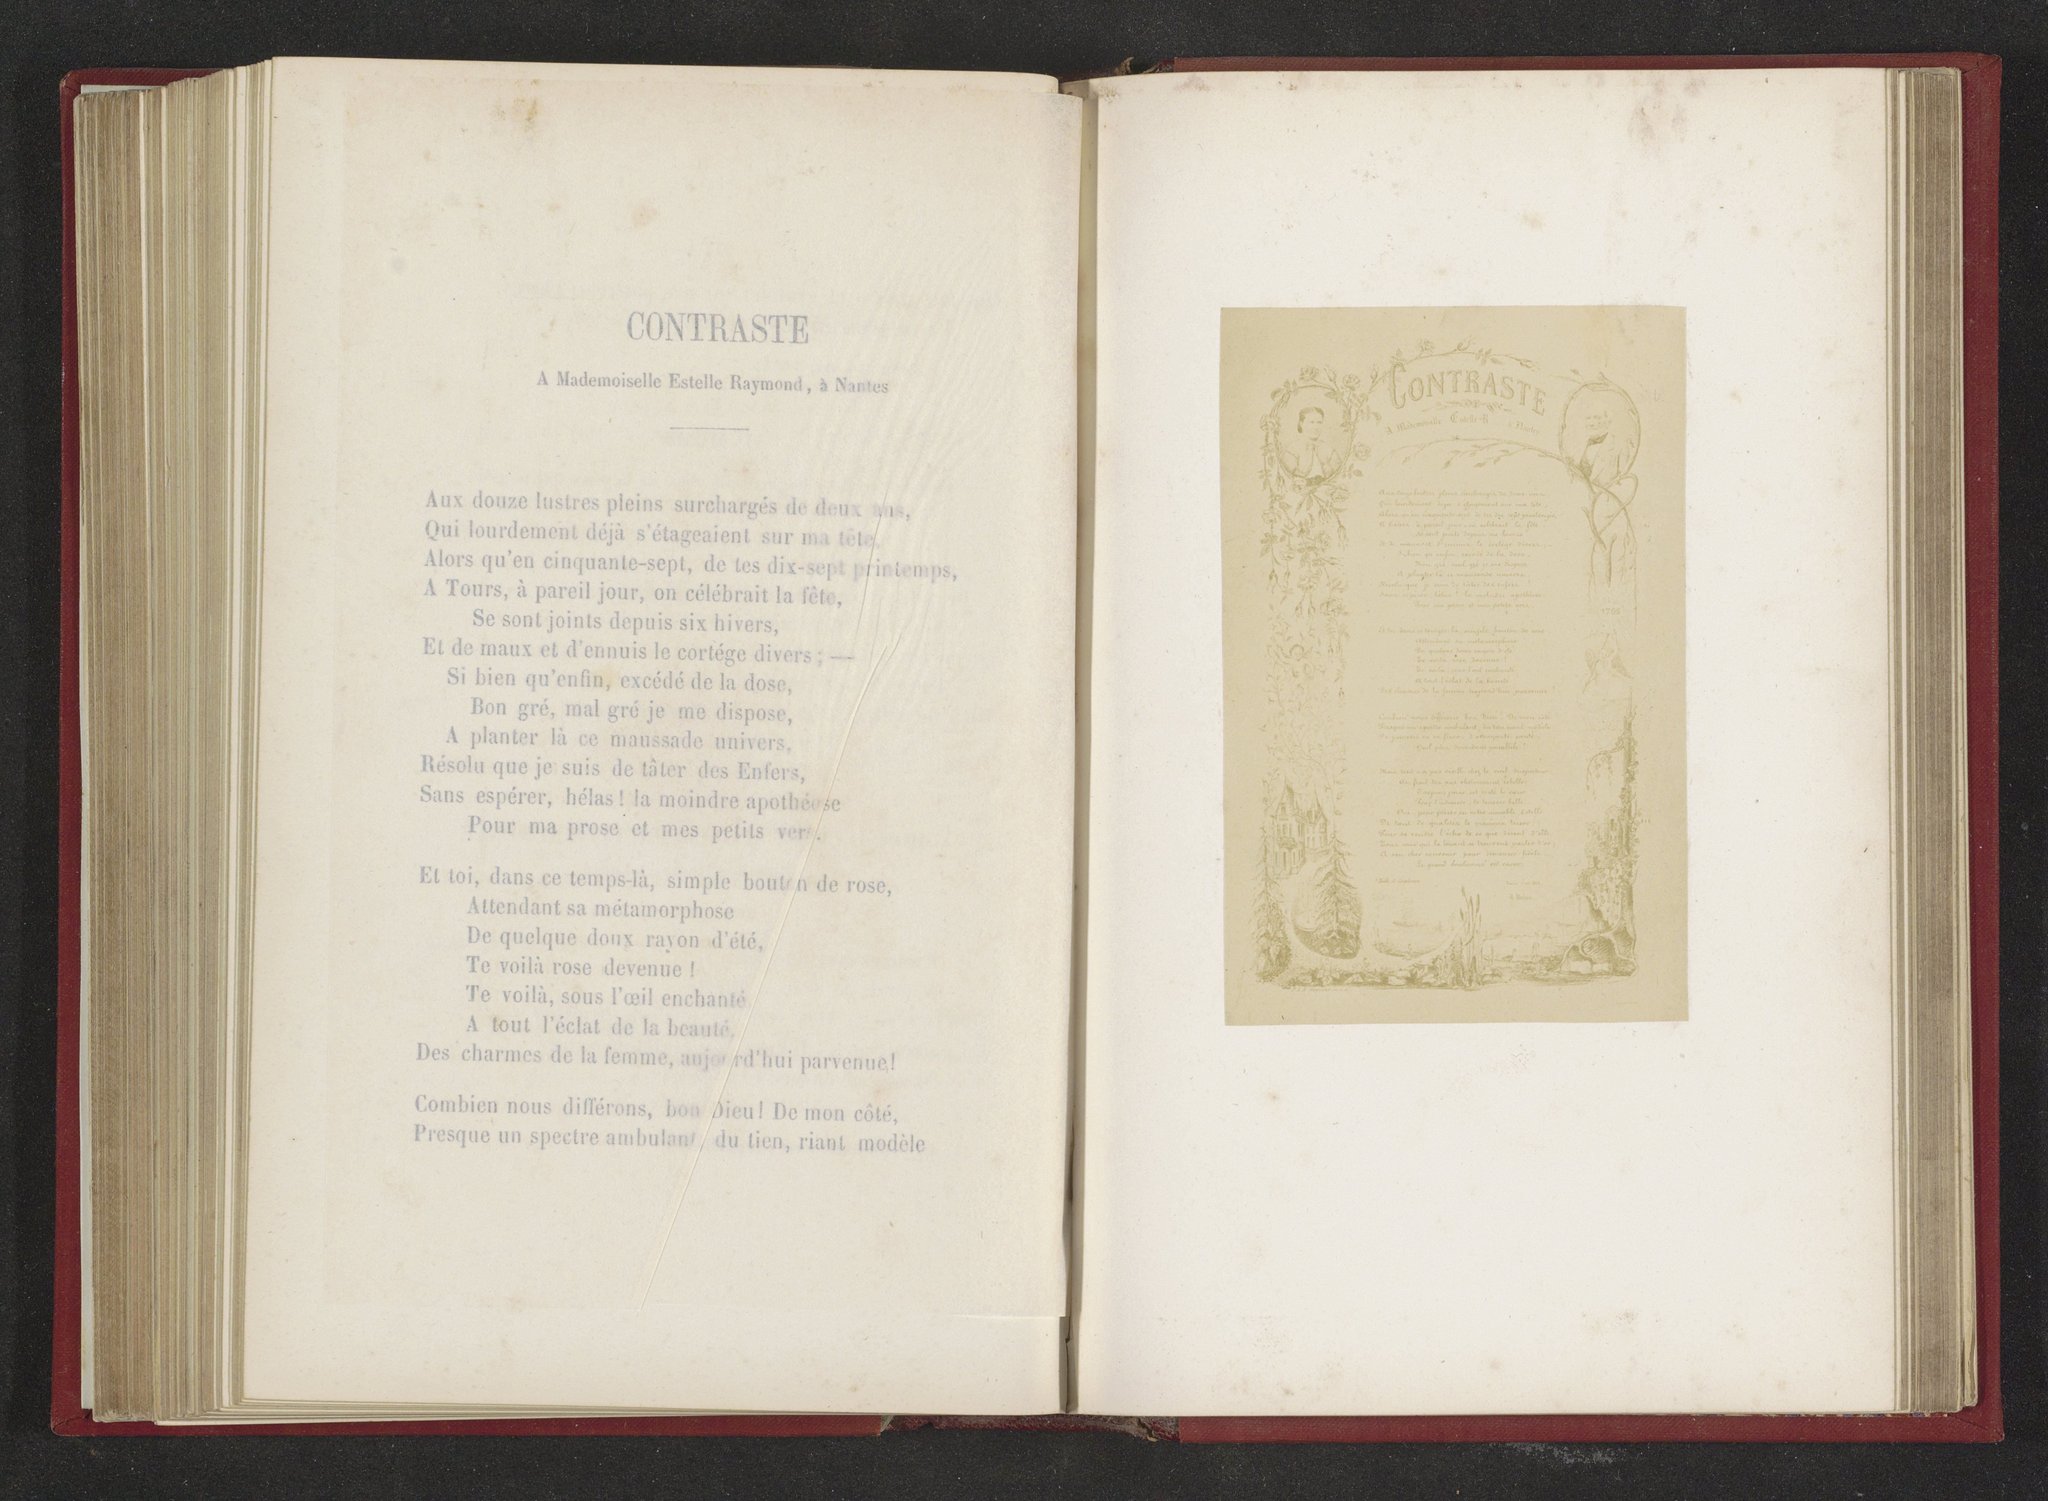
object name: page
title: Vers gedecoreerd met twee portretten en een huis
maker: collin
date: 1858-1868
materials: photographic support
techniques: albumen print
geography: paris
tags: historical persons, housing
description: Betreft het vers: Contraste door A. Dehen.